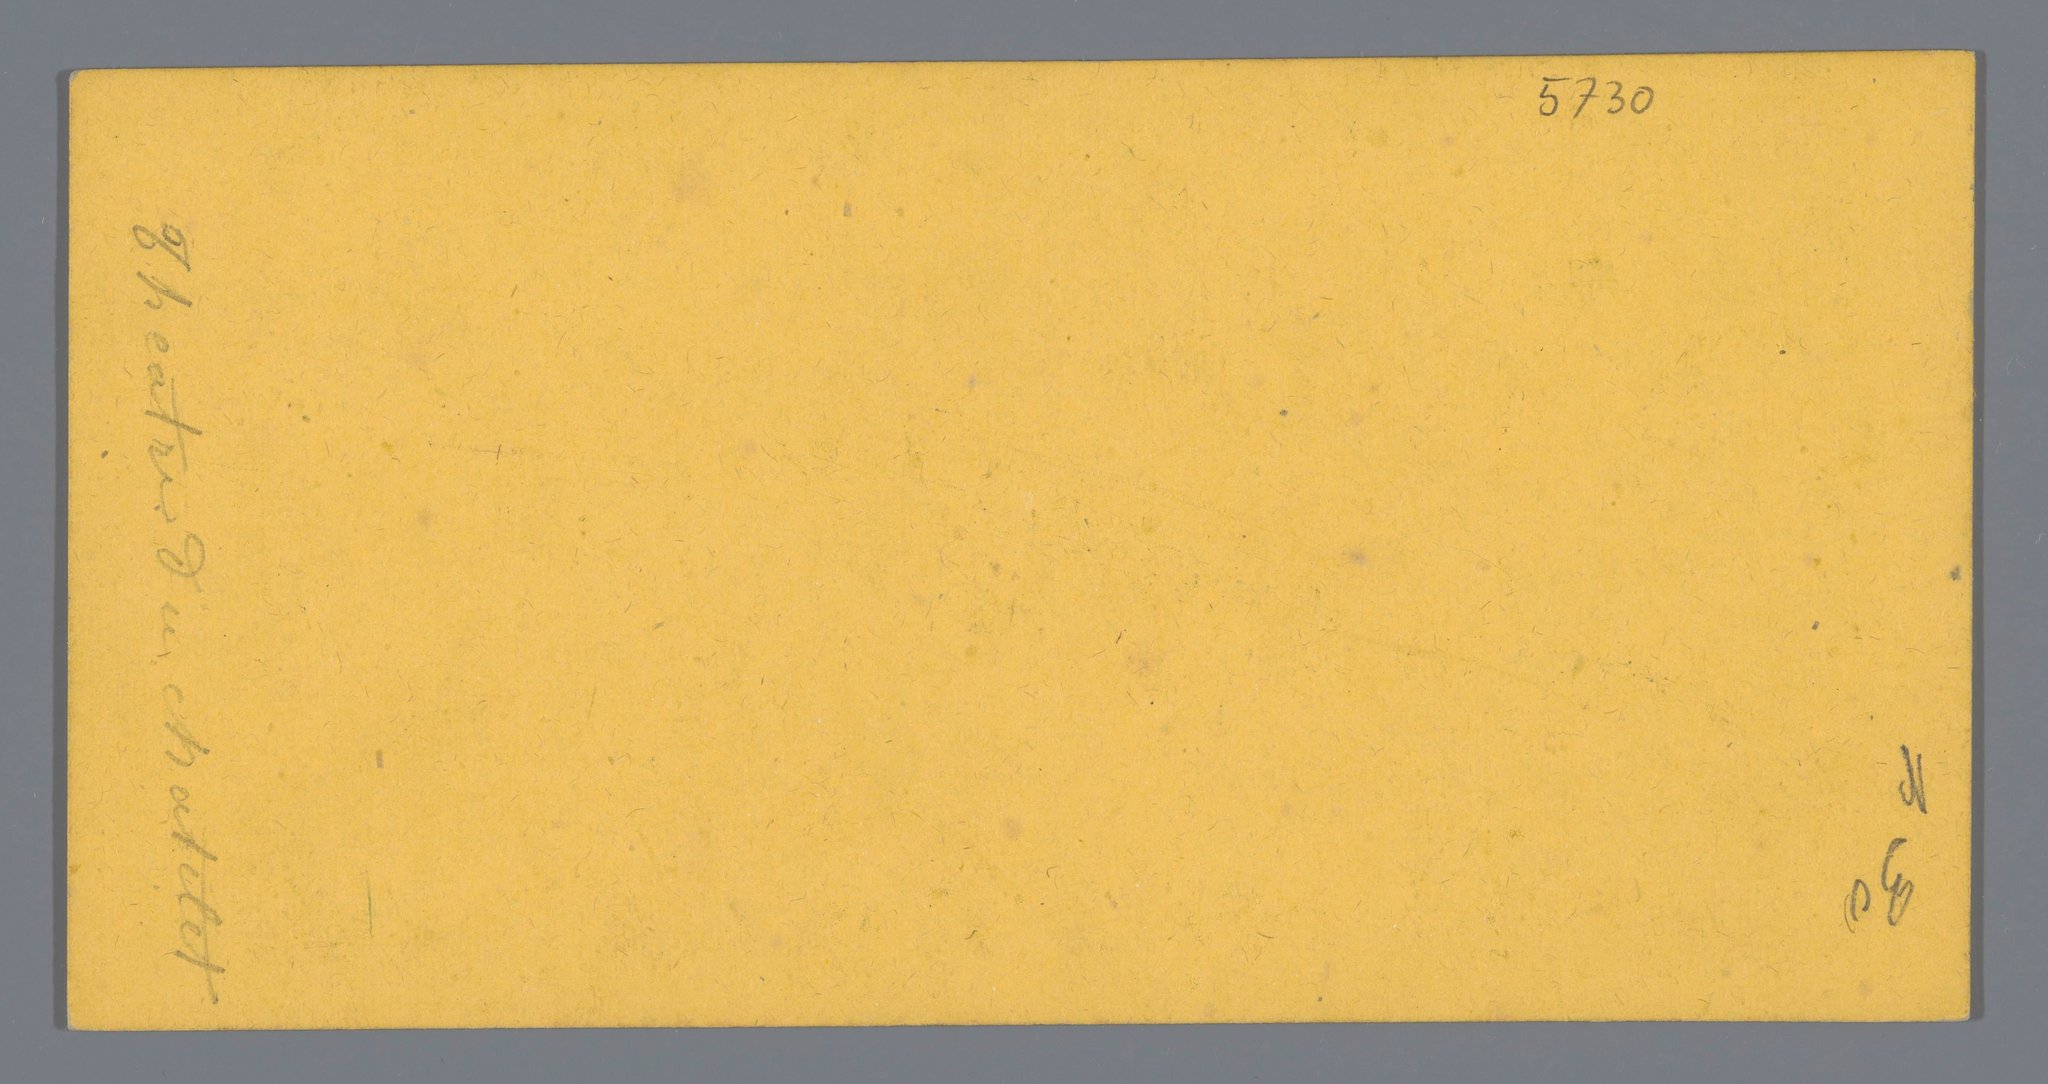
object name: stereograph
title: Gezicht op het Théâtre du Châtelet in Parijs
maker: Anonymous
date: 1862-1880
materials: cardboard, photographic support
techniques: albumen print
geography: paris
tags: theatre (building)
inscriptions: inscription: ‘Theatre du chatelet’, number: ‘30’